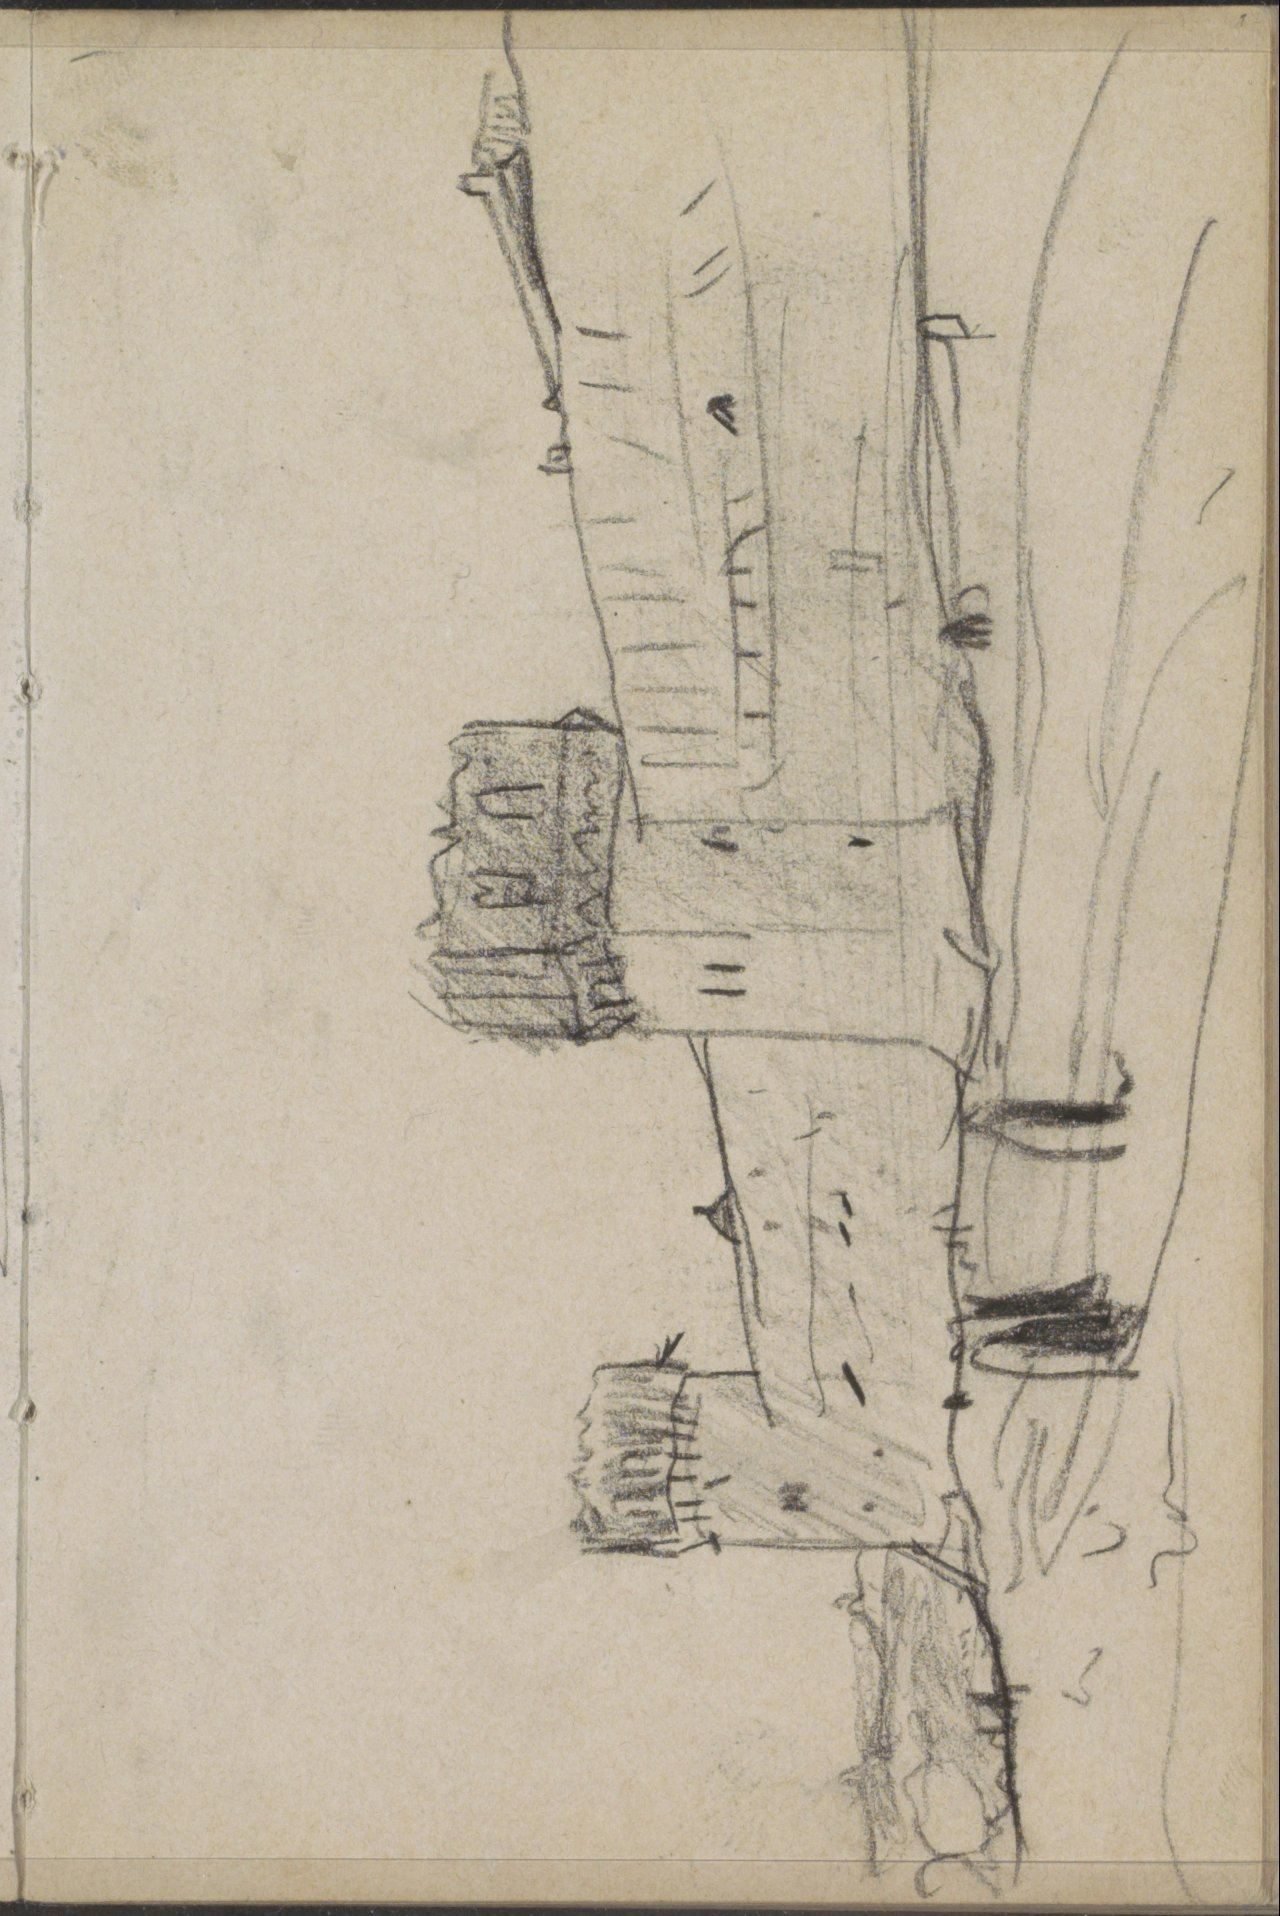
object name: sketchbook leaf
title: Verdedigingsmuur met twee torens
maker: marius bauer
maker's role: draughtsman, print maker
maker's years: 1867-1932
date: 1896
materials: chalk, paper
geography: moscow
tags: towers ~ fortified city, walls ~ fortified city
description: Mogelijk een deel van de muur om het Kremlin. Pagina 7 uit een schetsboek met 45 bladen.